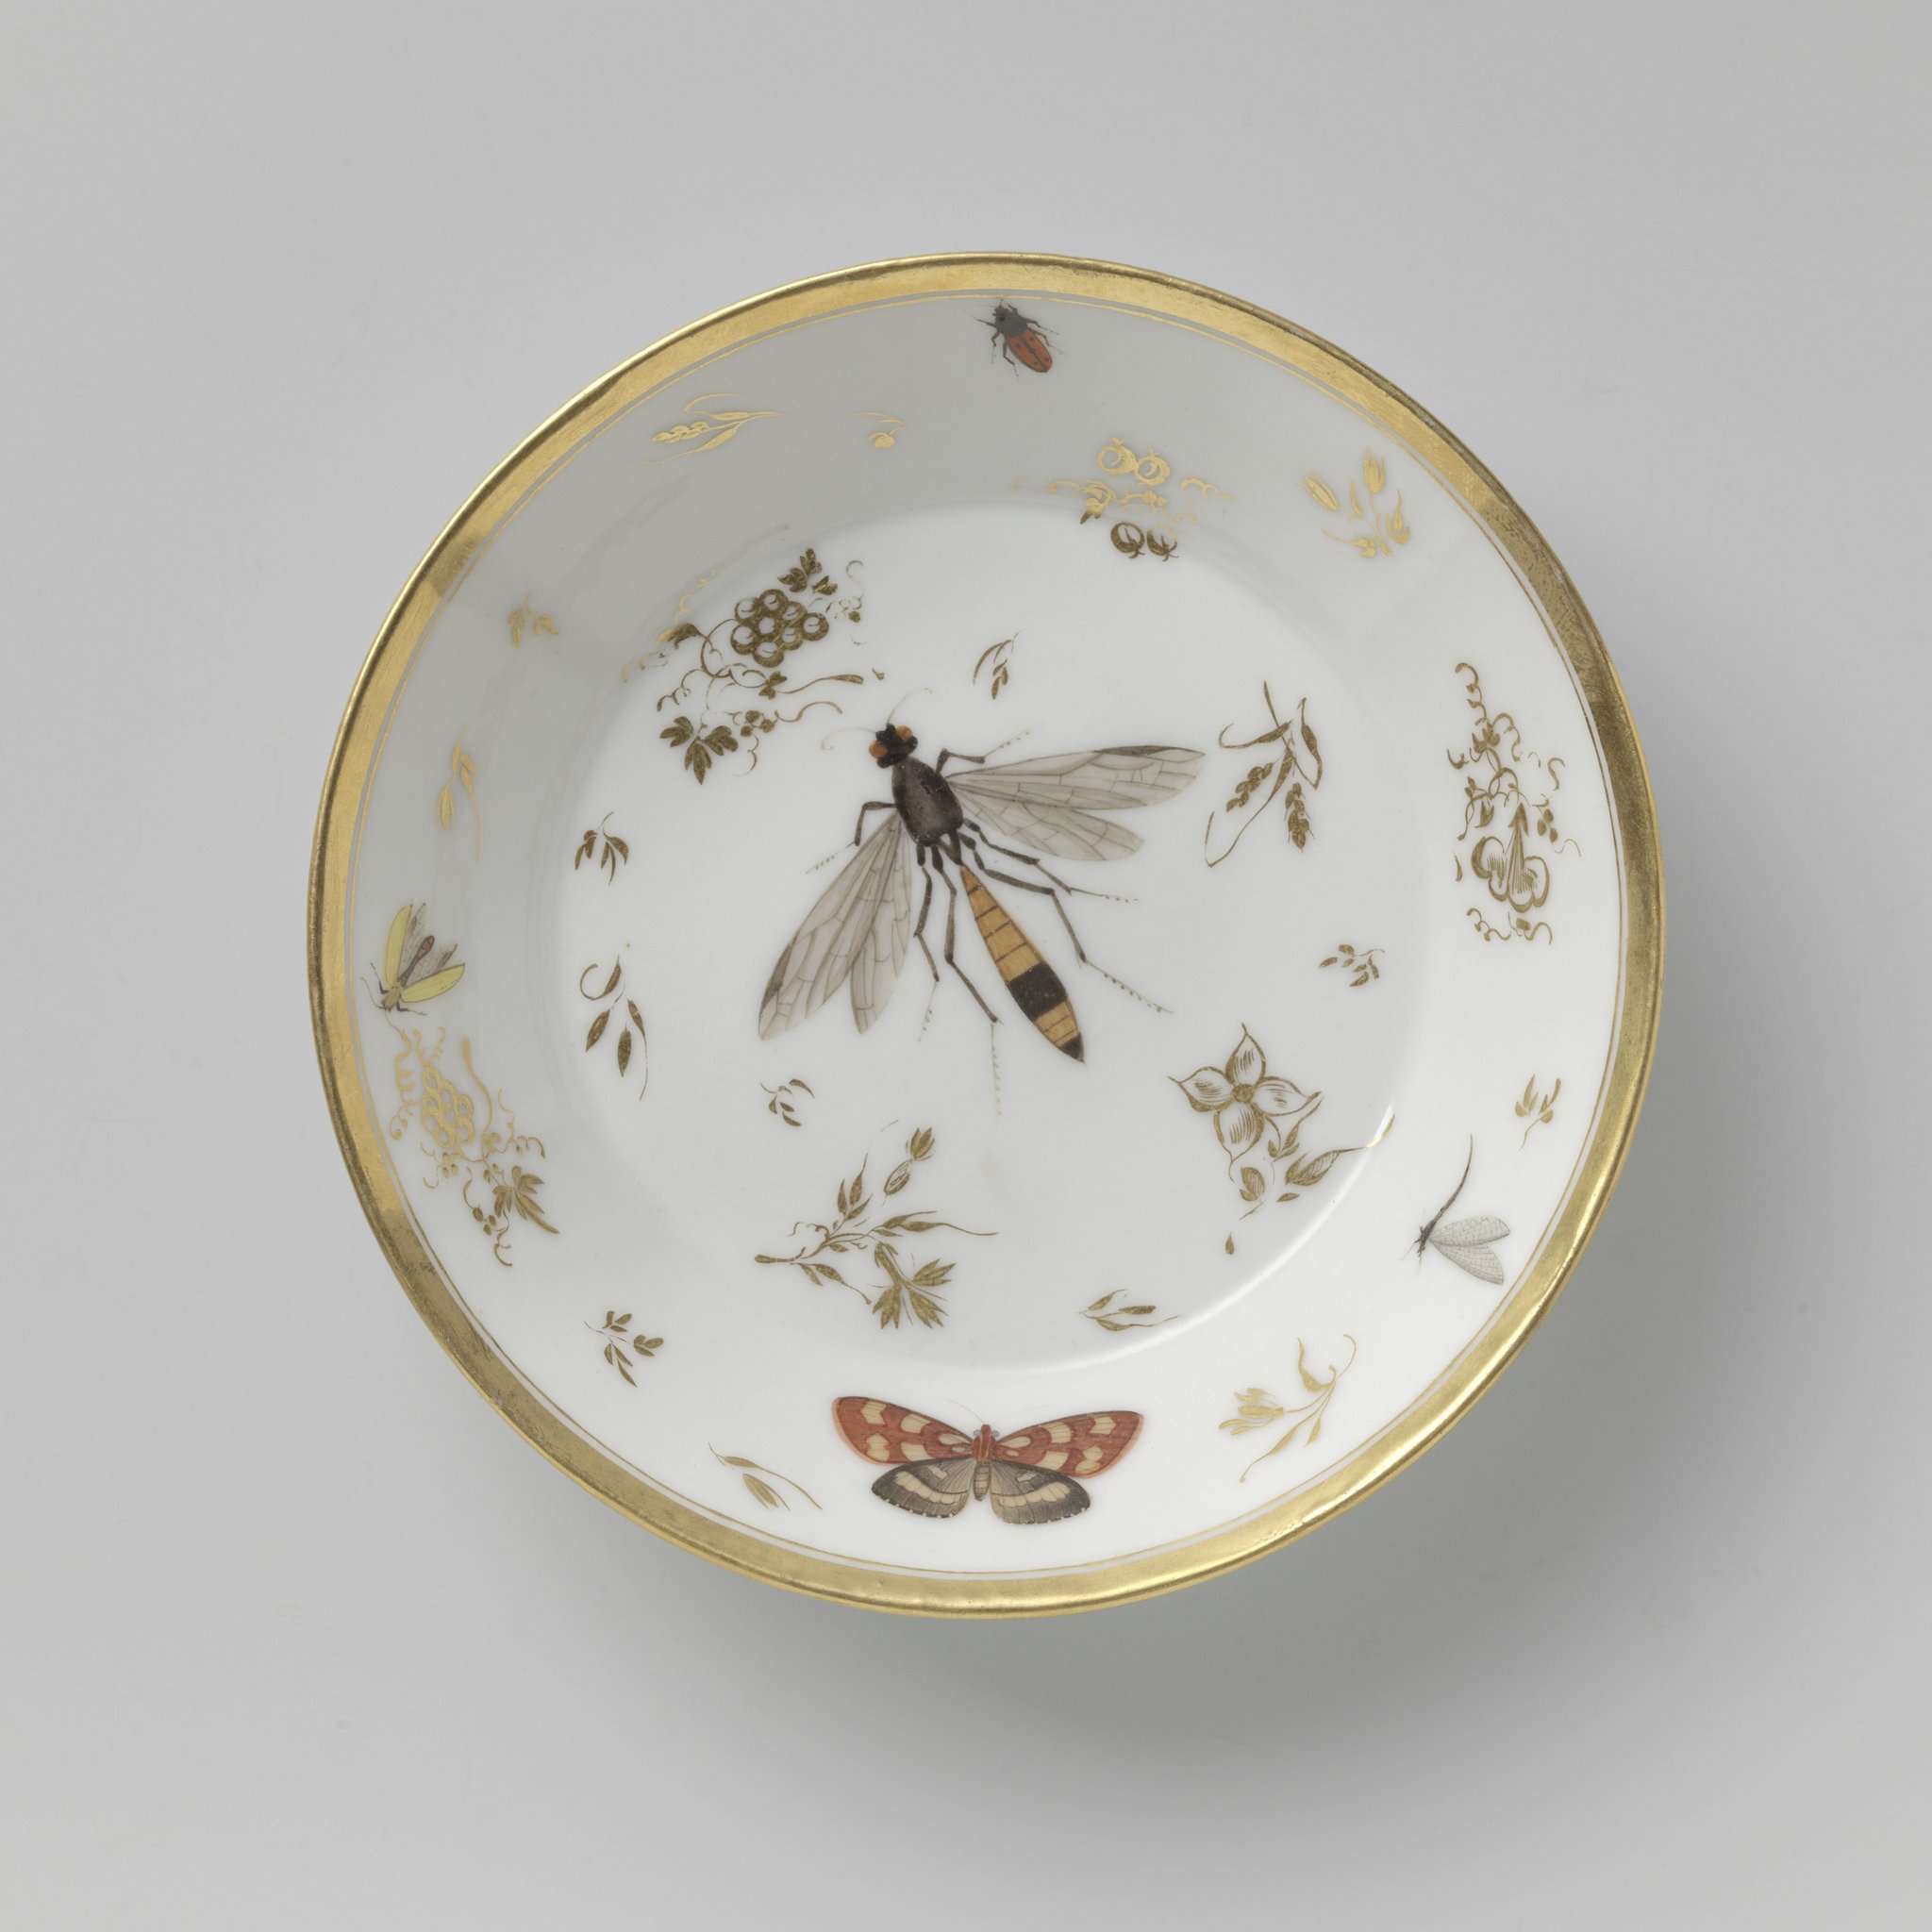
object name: platter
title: Saucer with insects, flower sprays and grapevines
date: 1797-1798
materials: glaze, gold, paint, porcelain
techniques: firing, forming, gilding, turning, vitrification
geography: paris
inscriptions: mark: ‘GB/ Rue Thiroux/ à Paris’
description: Schotel van porselein met een rechte wand, beschilderd op het glazuur in emailkleuren en goud. De voorzijde is bedekt met gekleurde insecten (vlinders, kevers, libellen, etc.) en in goud bloemtakken en druivenranken. Gouden rand. Gemerkt op de onderzijde 'GB/ Rue Thiroux/ à Paris'.